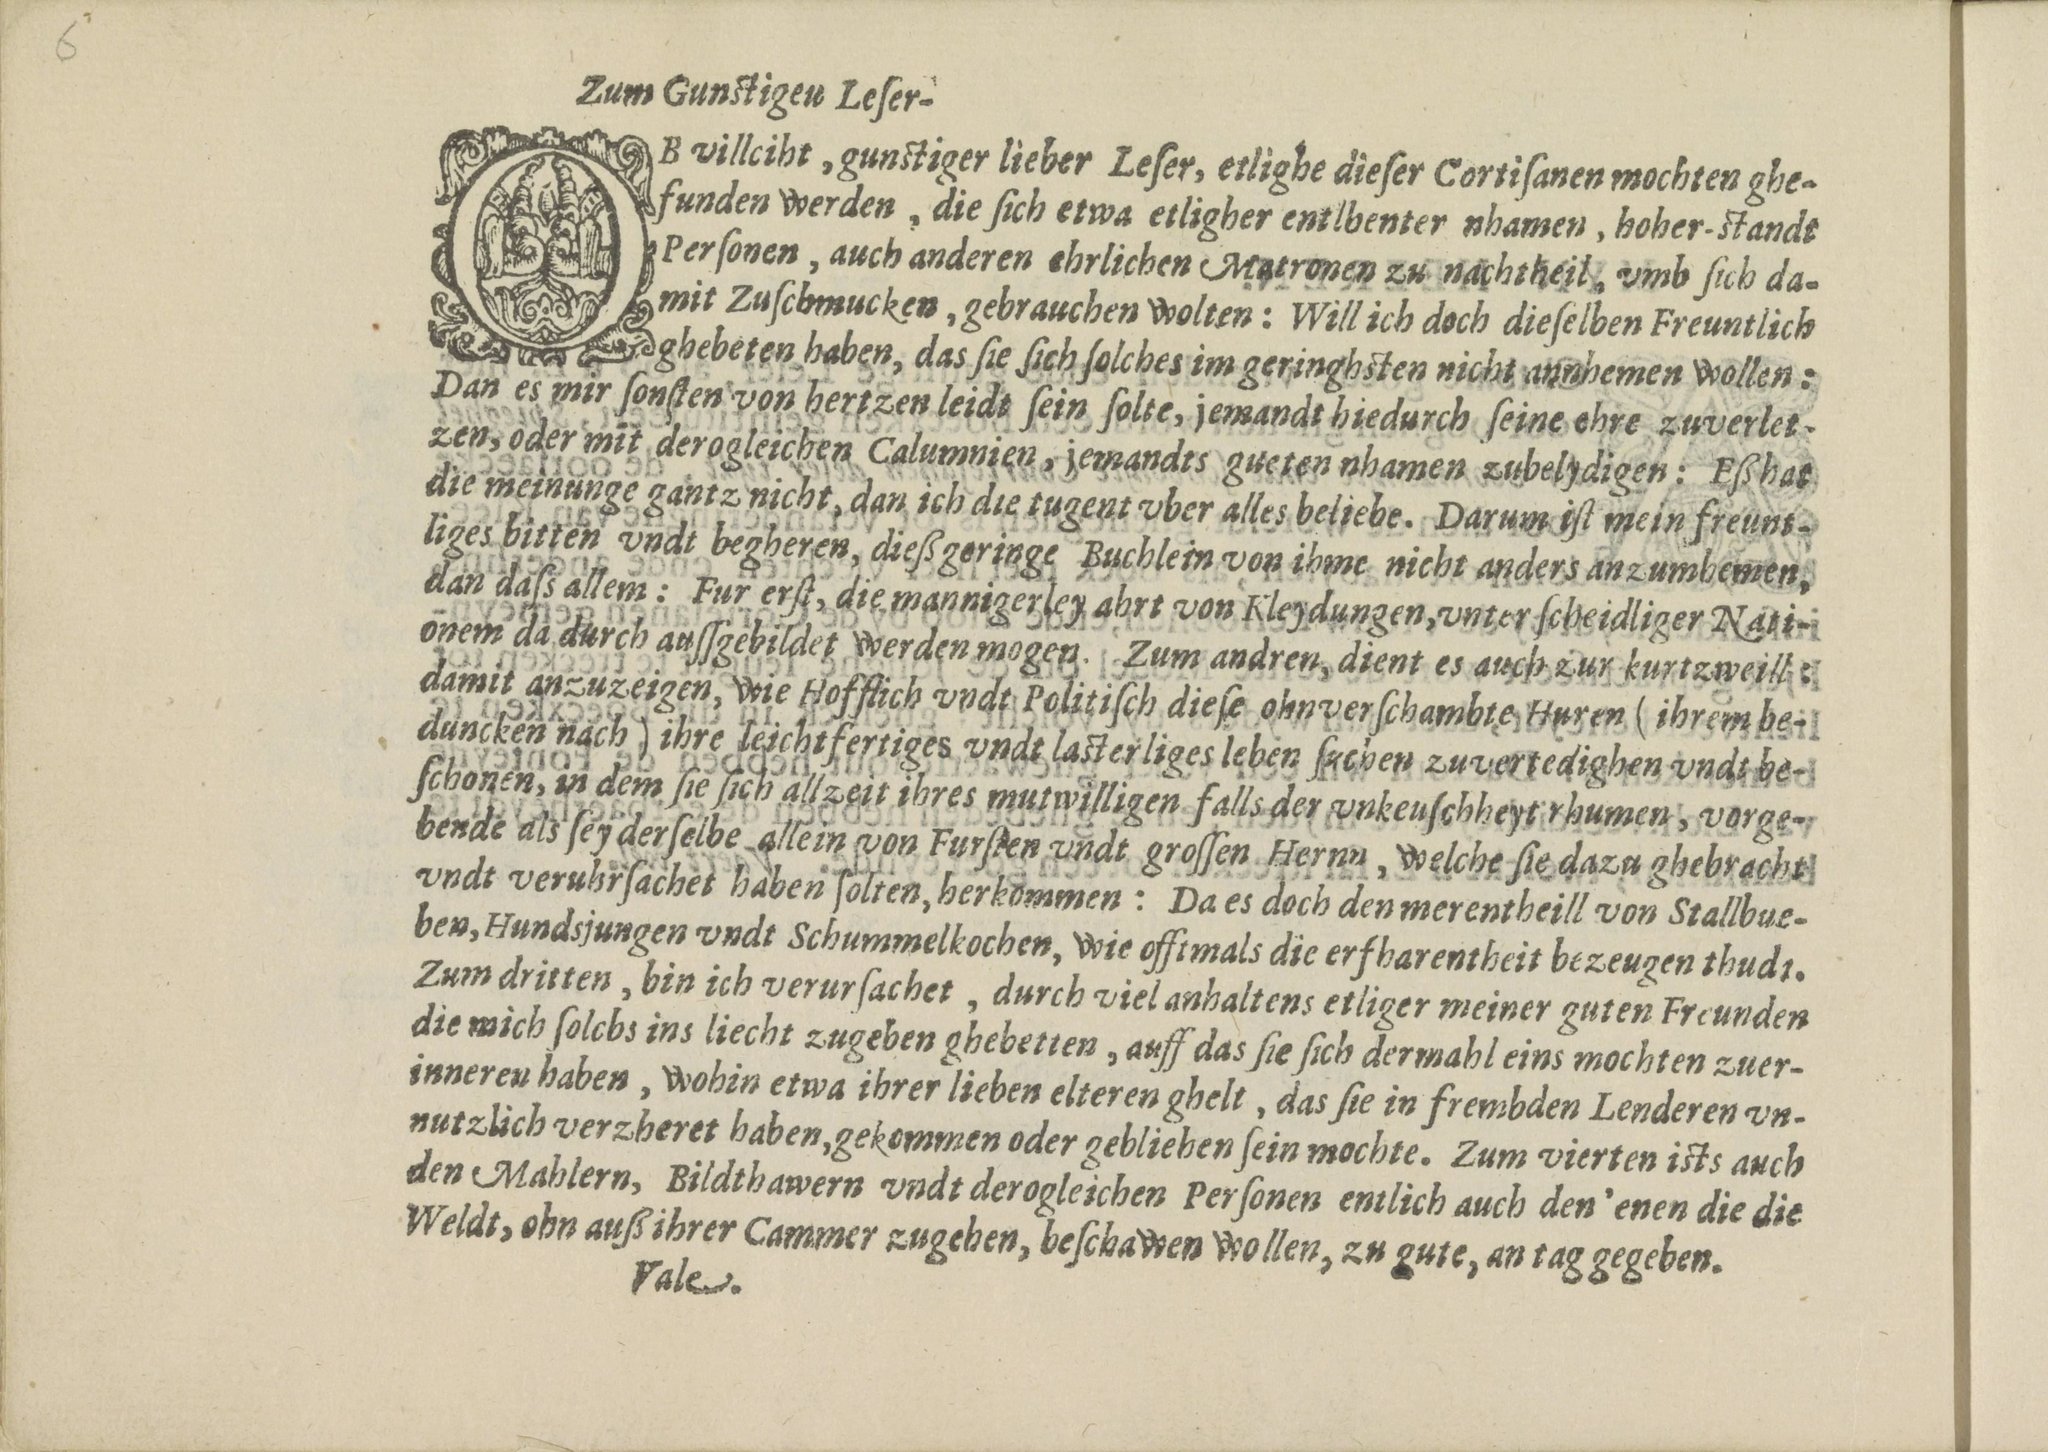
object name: album leaf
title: Zum Gunstigen Leser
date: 1635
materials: paper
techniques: letterpress printing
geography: utrecht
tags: initial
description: Duitstalig voorwoord met de aanhef: Zum Gunstigen Leser. De tekst vangt aan met een gedecoreerde initiaal O. Het blad maakt deel uit van een album.